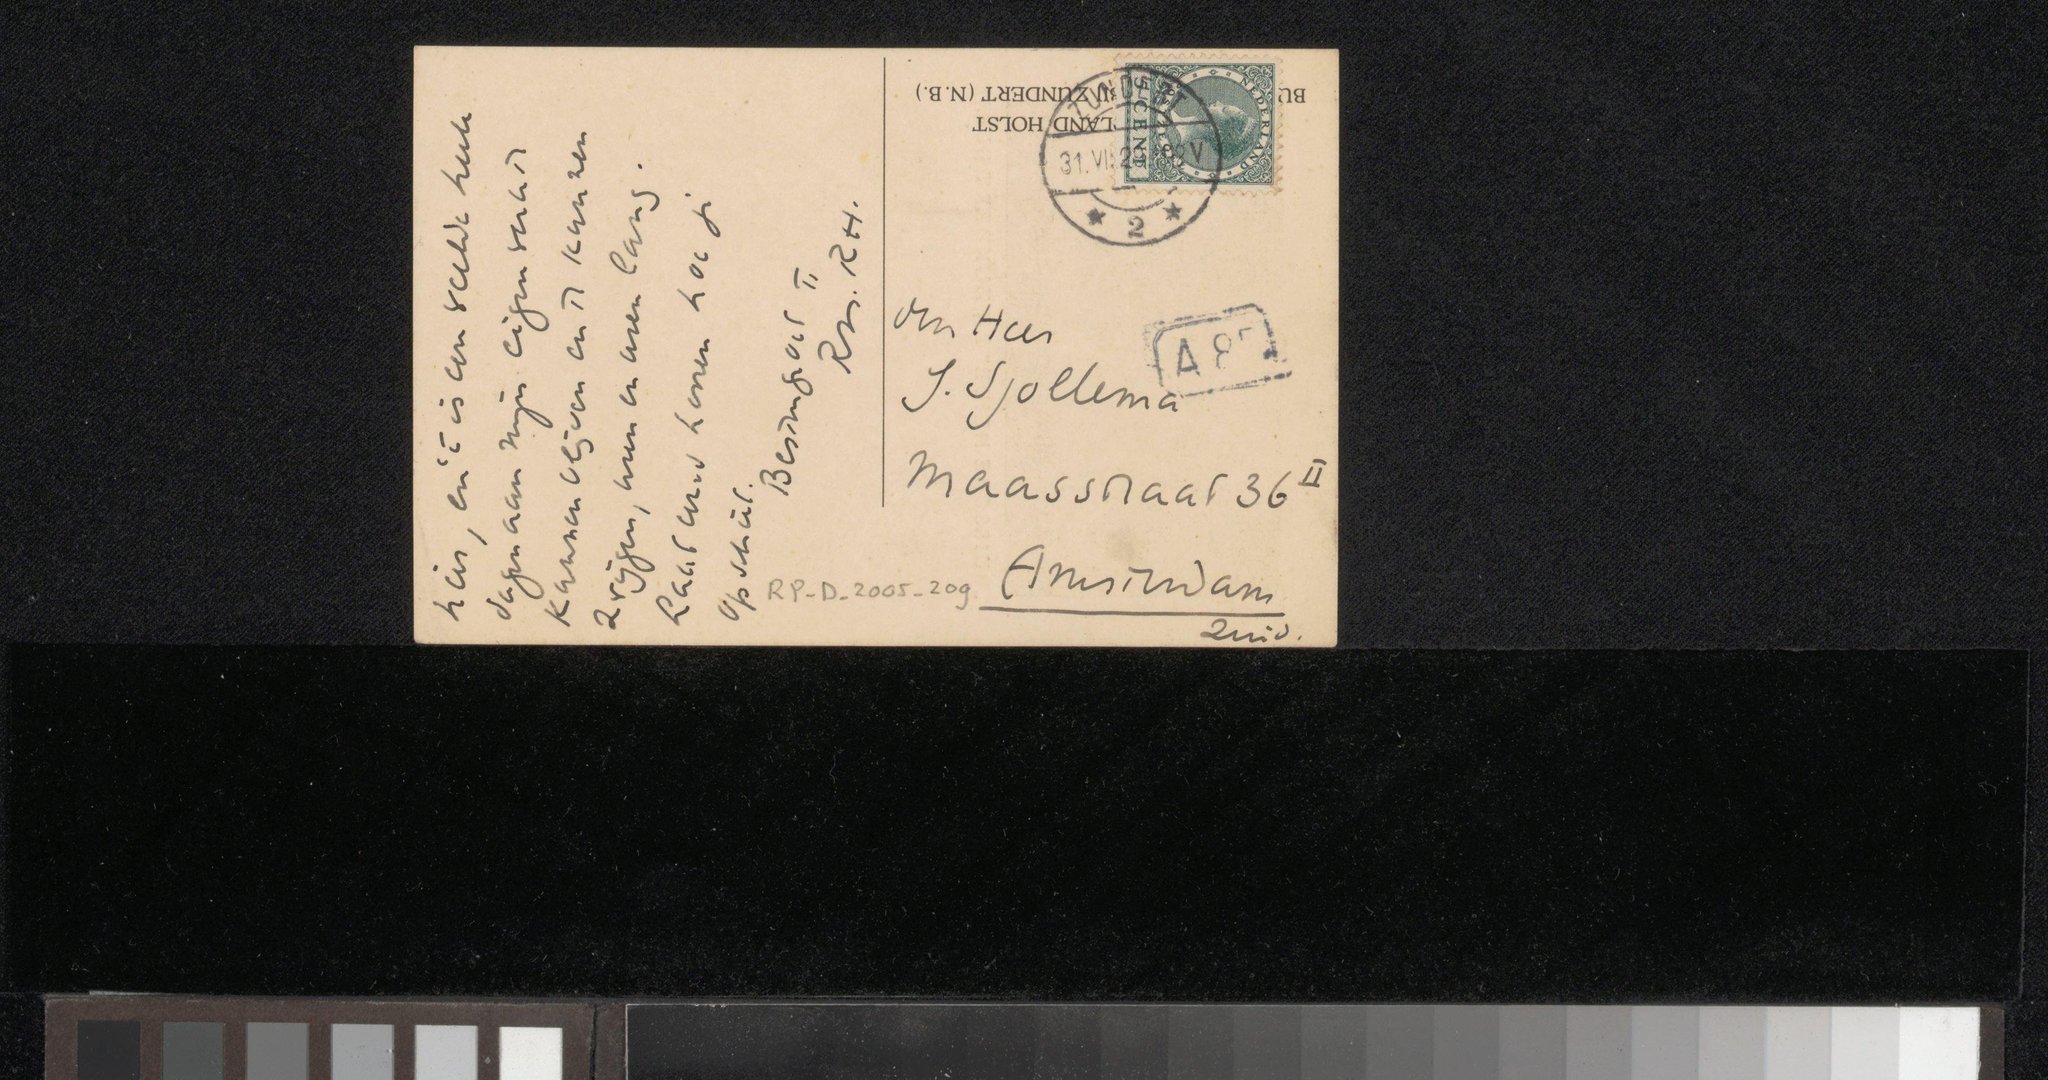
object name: ansichtkaart, prentbriefkaart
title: Prentbriefkaart aan Joop Sjollema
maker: richard nicolaüs roland holst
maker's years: 1868-1938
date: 1929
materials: cardboard, ink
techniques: pen, writing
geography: zundert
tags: amsterdam, print maker, draughtsman, joop sjollema